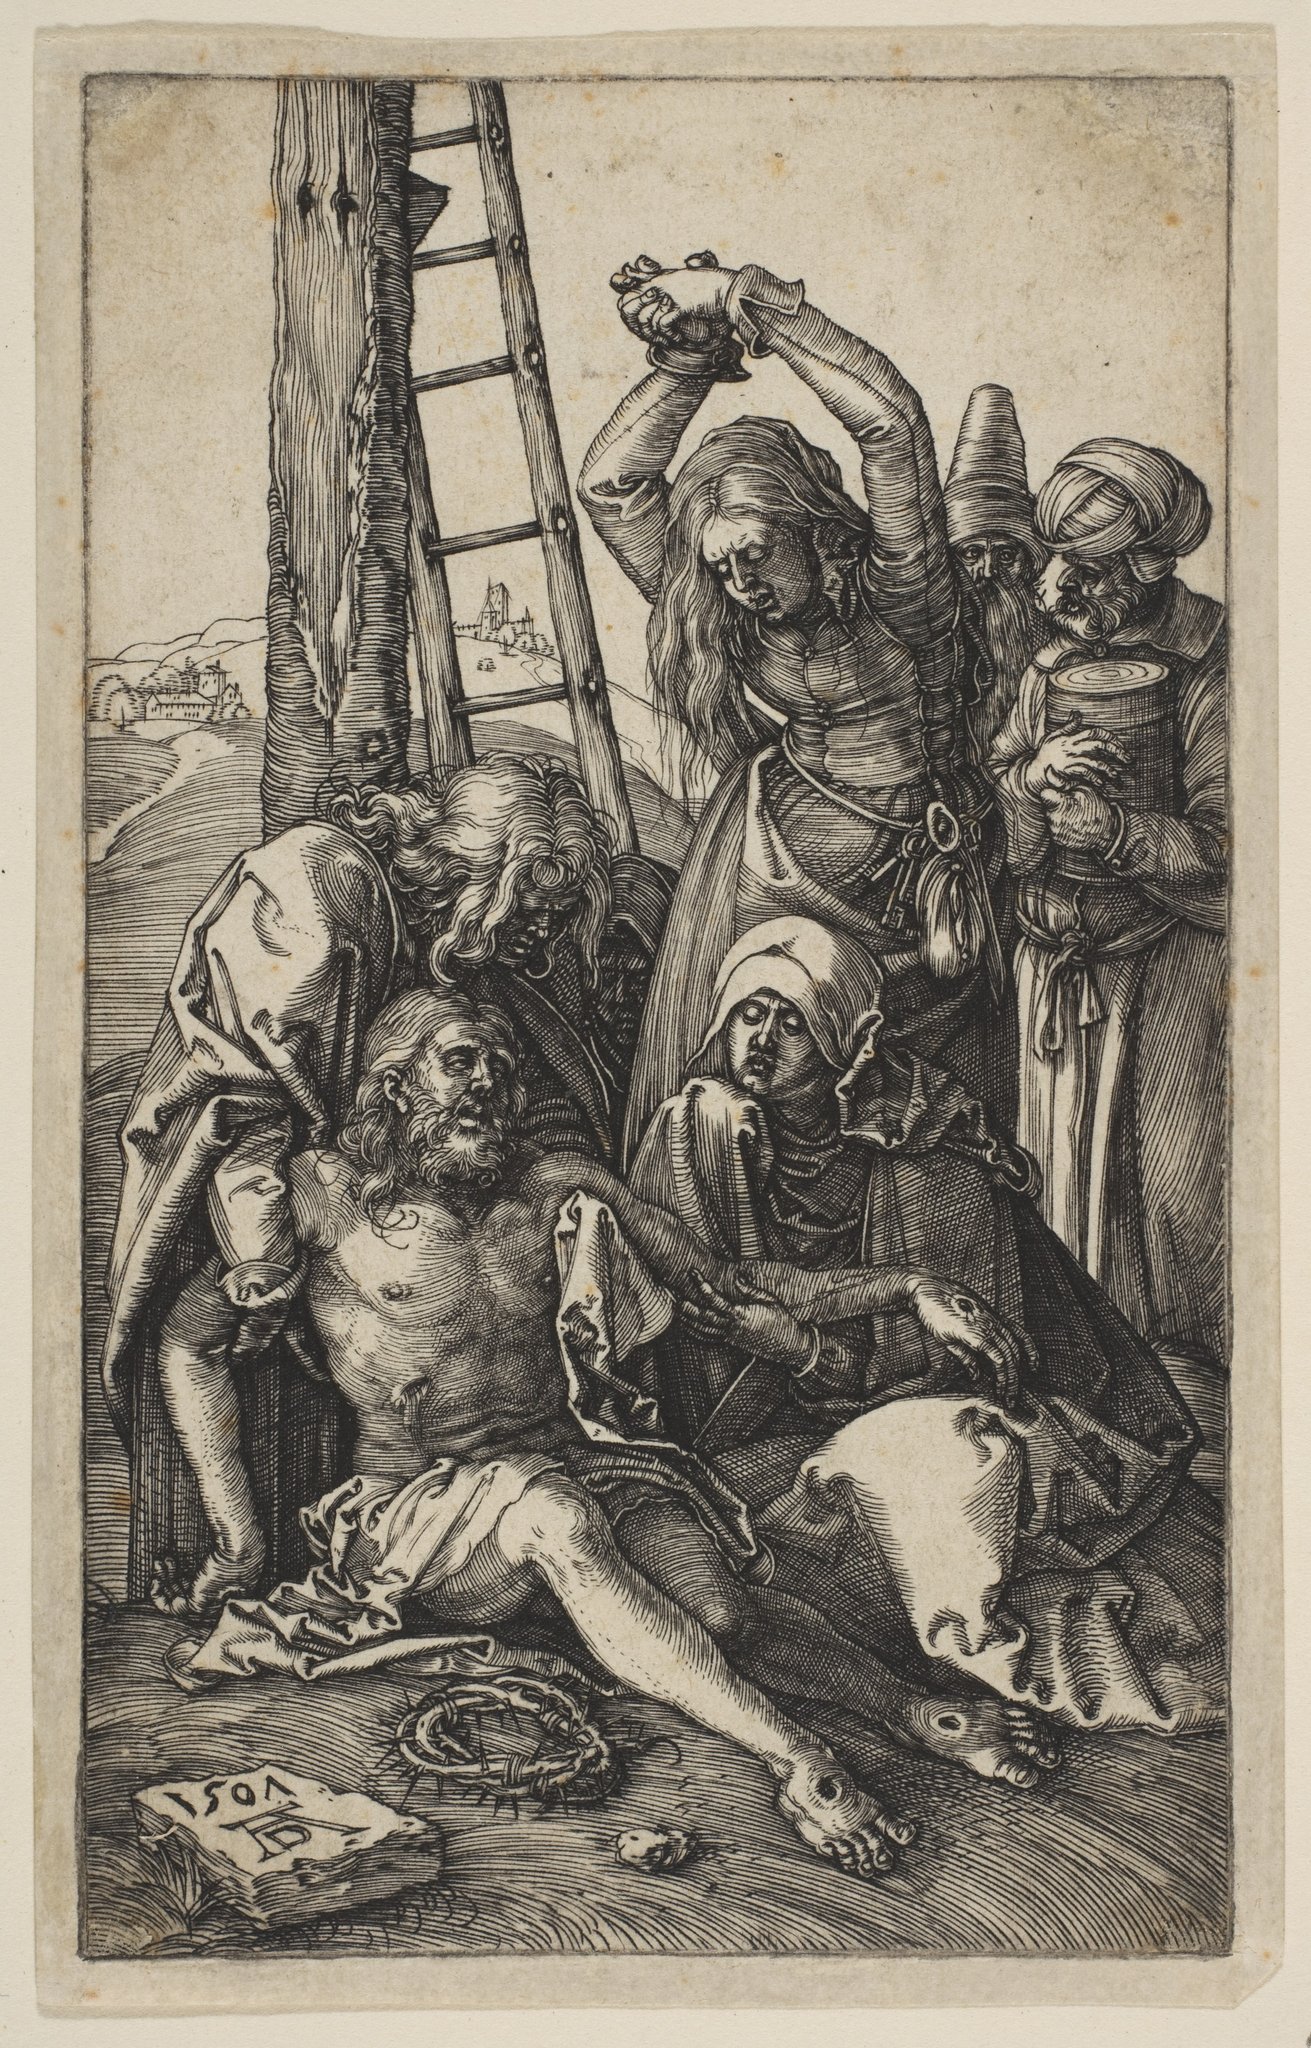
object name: print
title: The Lamentation, from "The Passion"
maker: albrecht dürer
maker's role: artist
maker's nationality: german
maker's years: 1471-1528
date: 1507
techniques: engraving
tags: men,women,christ,lamentation,ladders